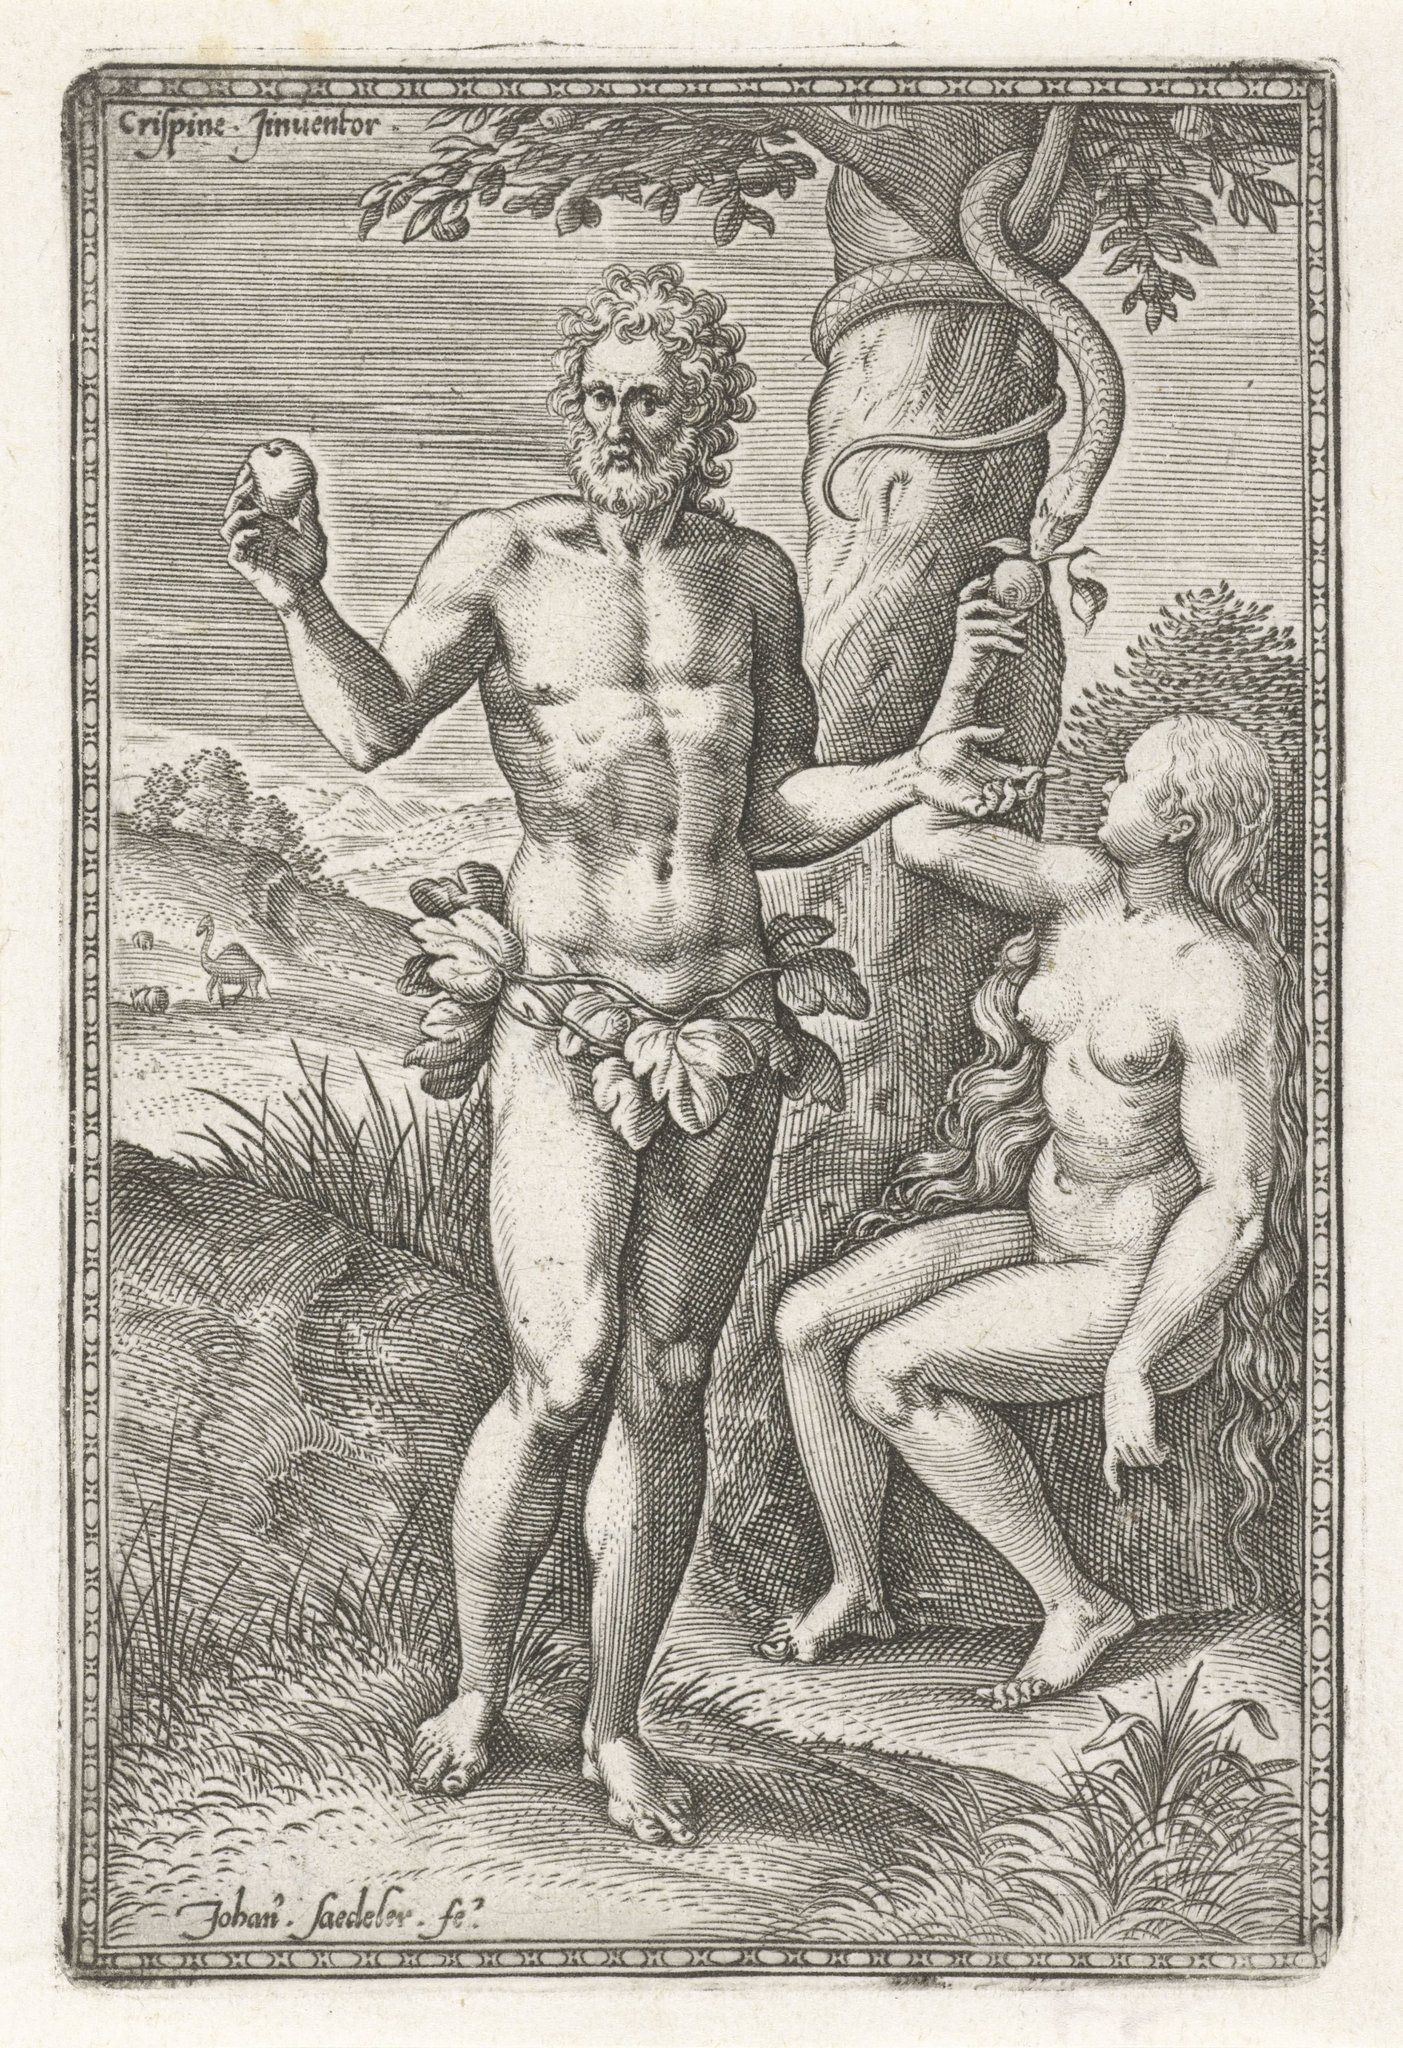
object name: print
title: Personen uit het Oude Testament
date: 1575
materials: paper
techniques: engraving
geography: antwerp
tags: adam and eve (not in biblical context)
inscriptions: collector's mark: Lugt 240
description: Adam en Eva onder de boom van de kennis van goed en kwaad. Adam op de voorgrond met een vrucht in de rechterhand. Eva krijgt van de slang een vrucht aangeboden. De eerste prent van een 39-delige reeks met als onderwerp personen uit het Oude Testament.